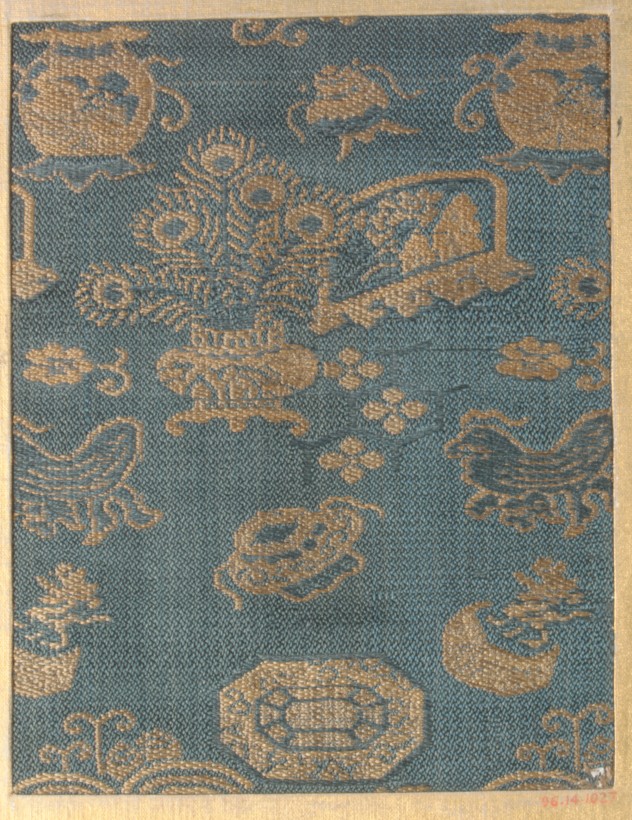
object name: piece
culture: japanese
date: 1701-1900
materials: silk